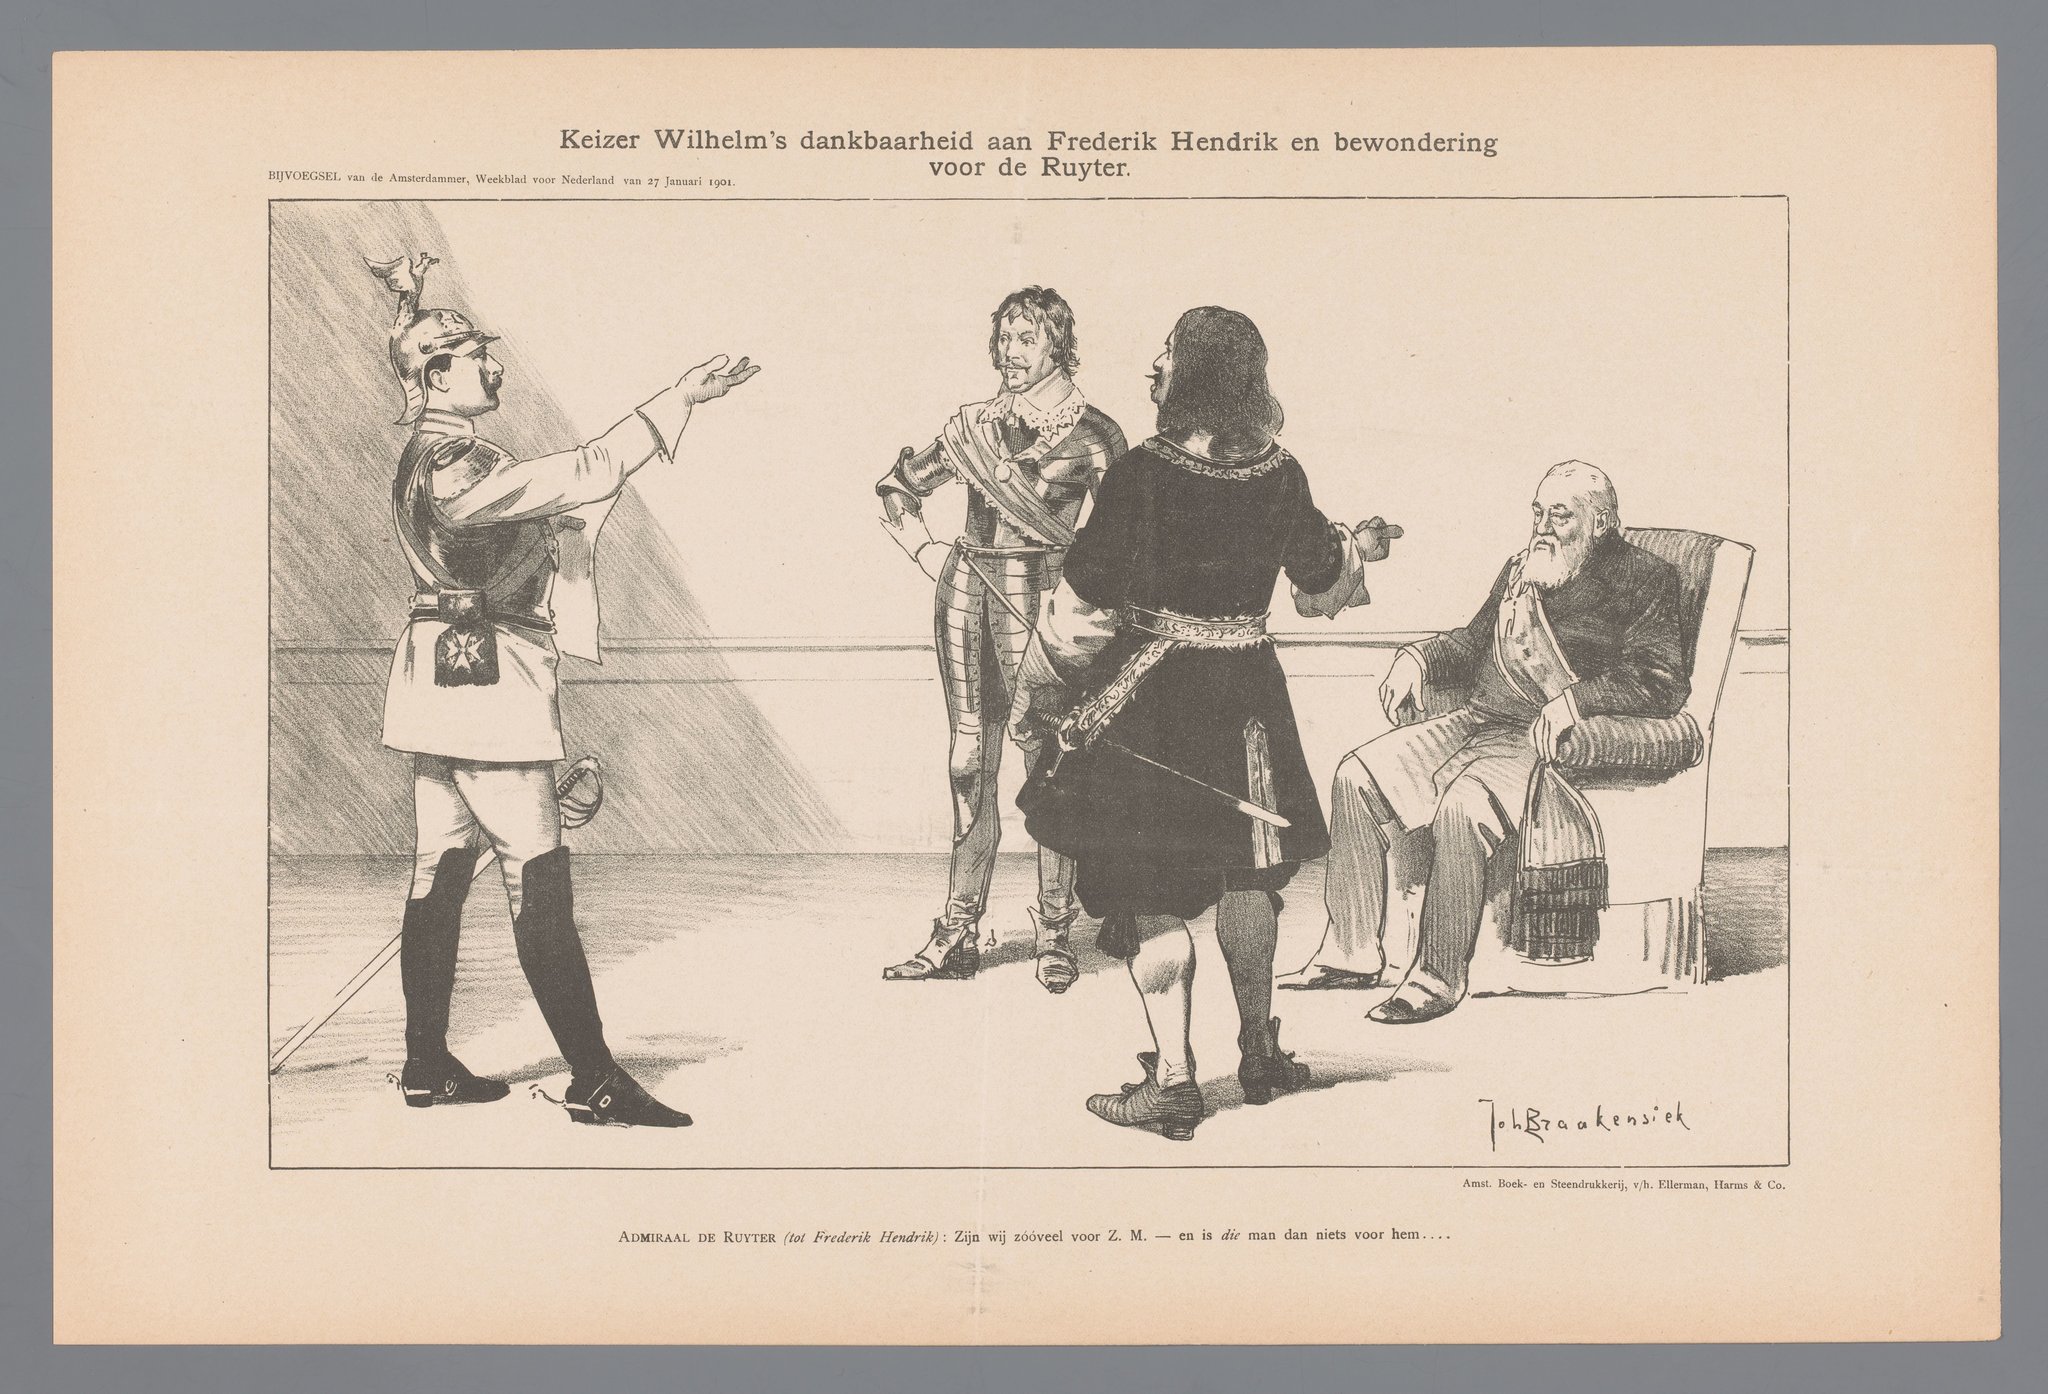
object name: cartoon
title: Keizer Wilhelm's dankbaarheid aan Frederik Hendrik en bewondering voor De Ruyter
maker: johan braakensiek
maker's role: draughtsman, print maker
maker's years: 1858-1940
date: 1901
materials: paper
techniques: lithograph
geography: amsterdam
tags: wilhelm ii (keizer van duitsland), flushing, michiel adriaenszoon de ruyter, delft, the hague, frederick henry (prince of orange), historical persons, ruler, sovereign, political caricatures and satires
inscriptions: date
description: Prent uit het bijvoegsel van: De Amsterdammer. Weekblad voor Nederland, 27 januari 1901.